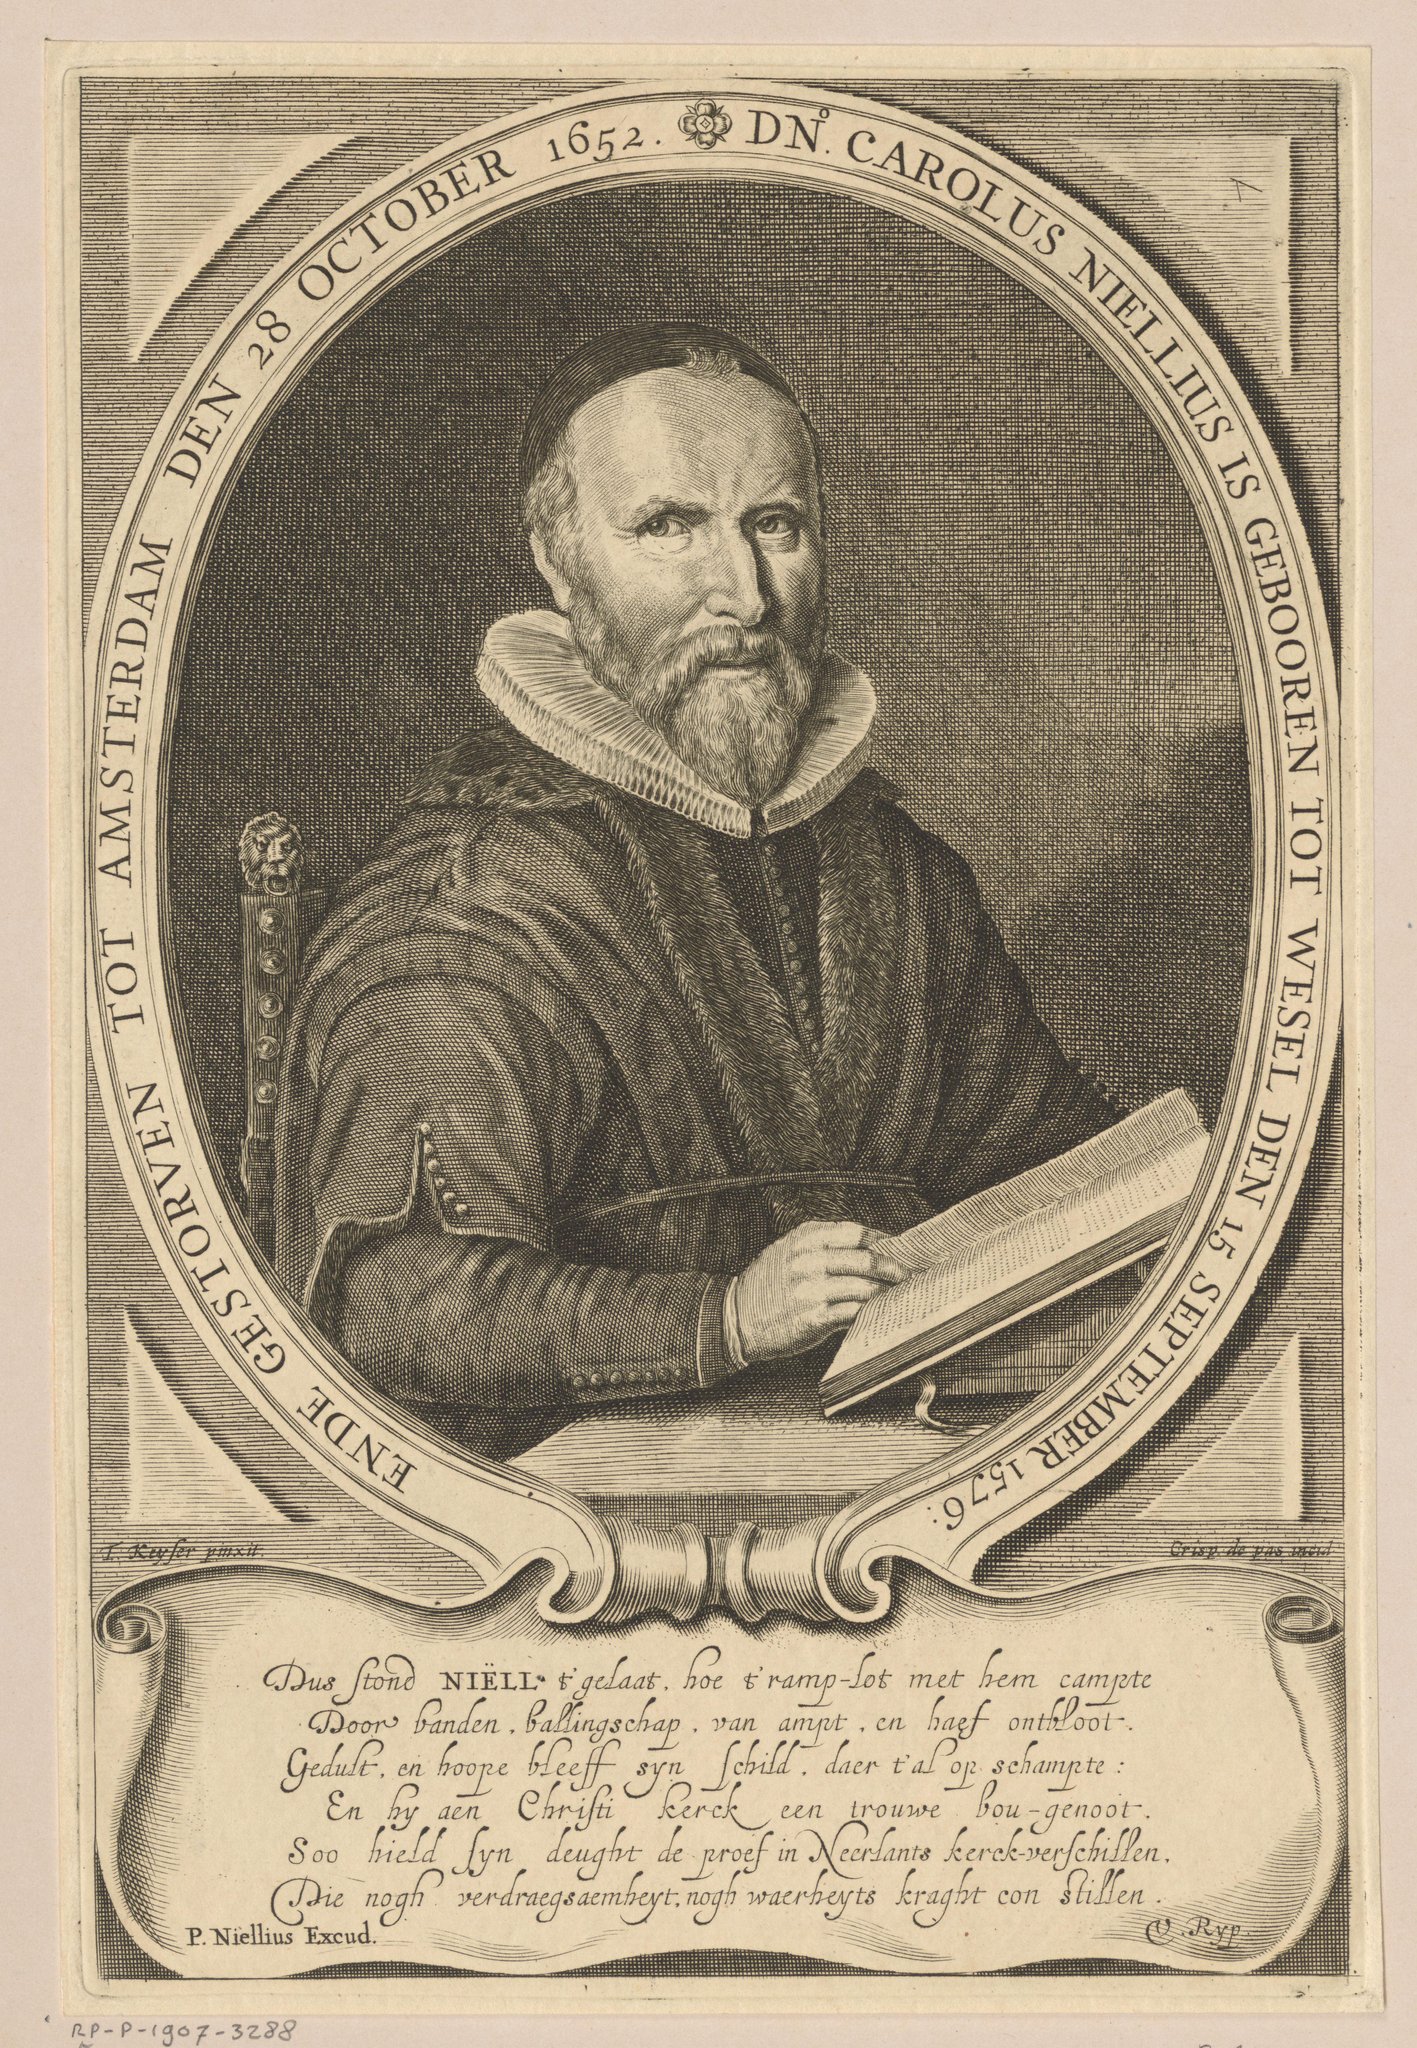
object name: print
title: Portret van Carolus Niellius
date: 1652-1659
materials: paper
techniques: engraving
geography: amsterdam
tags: historical persons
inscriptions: collector's mark: Lugt 2228